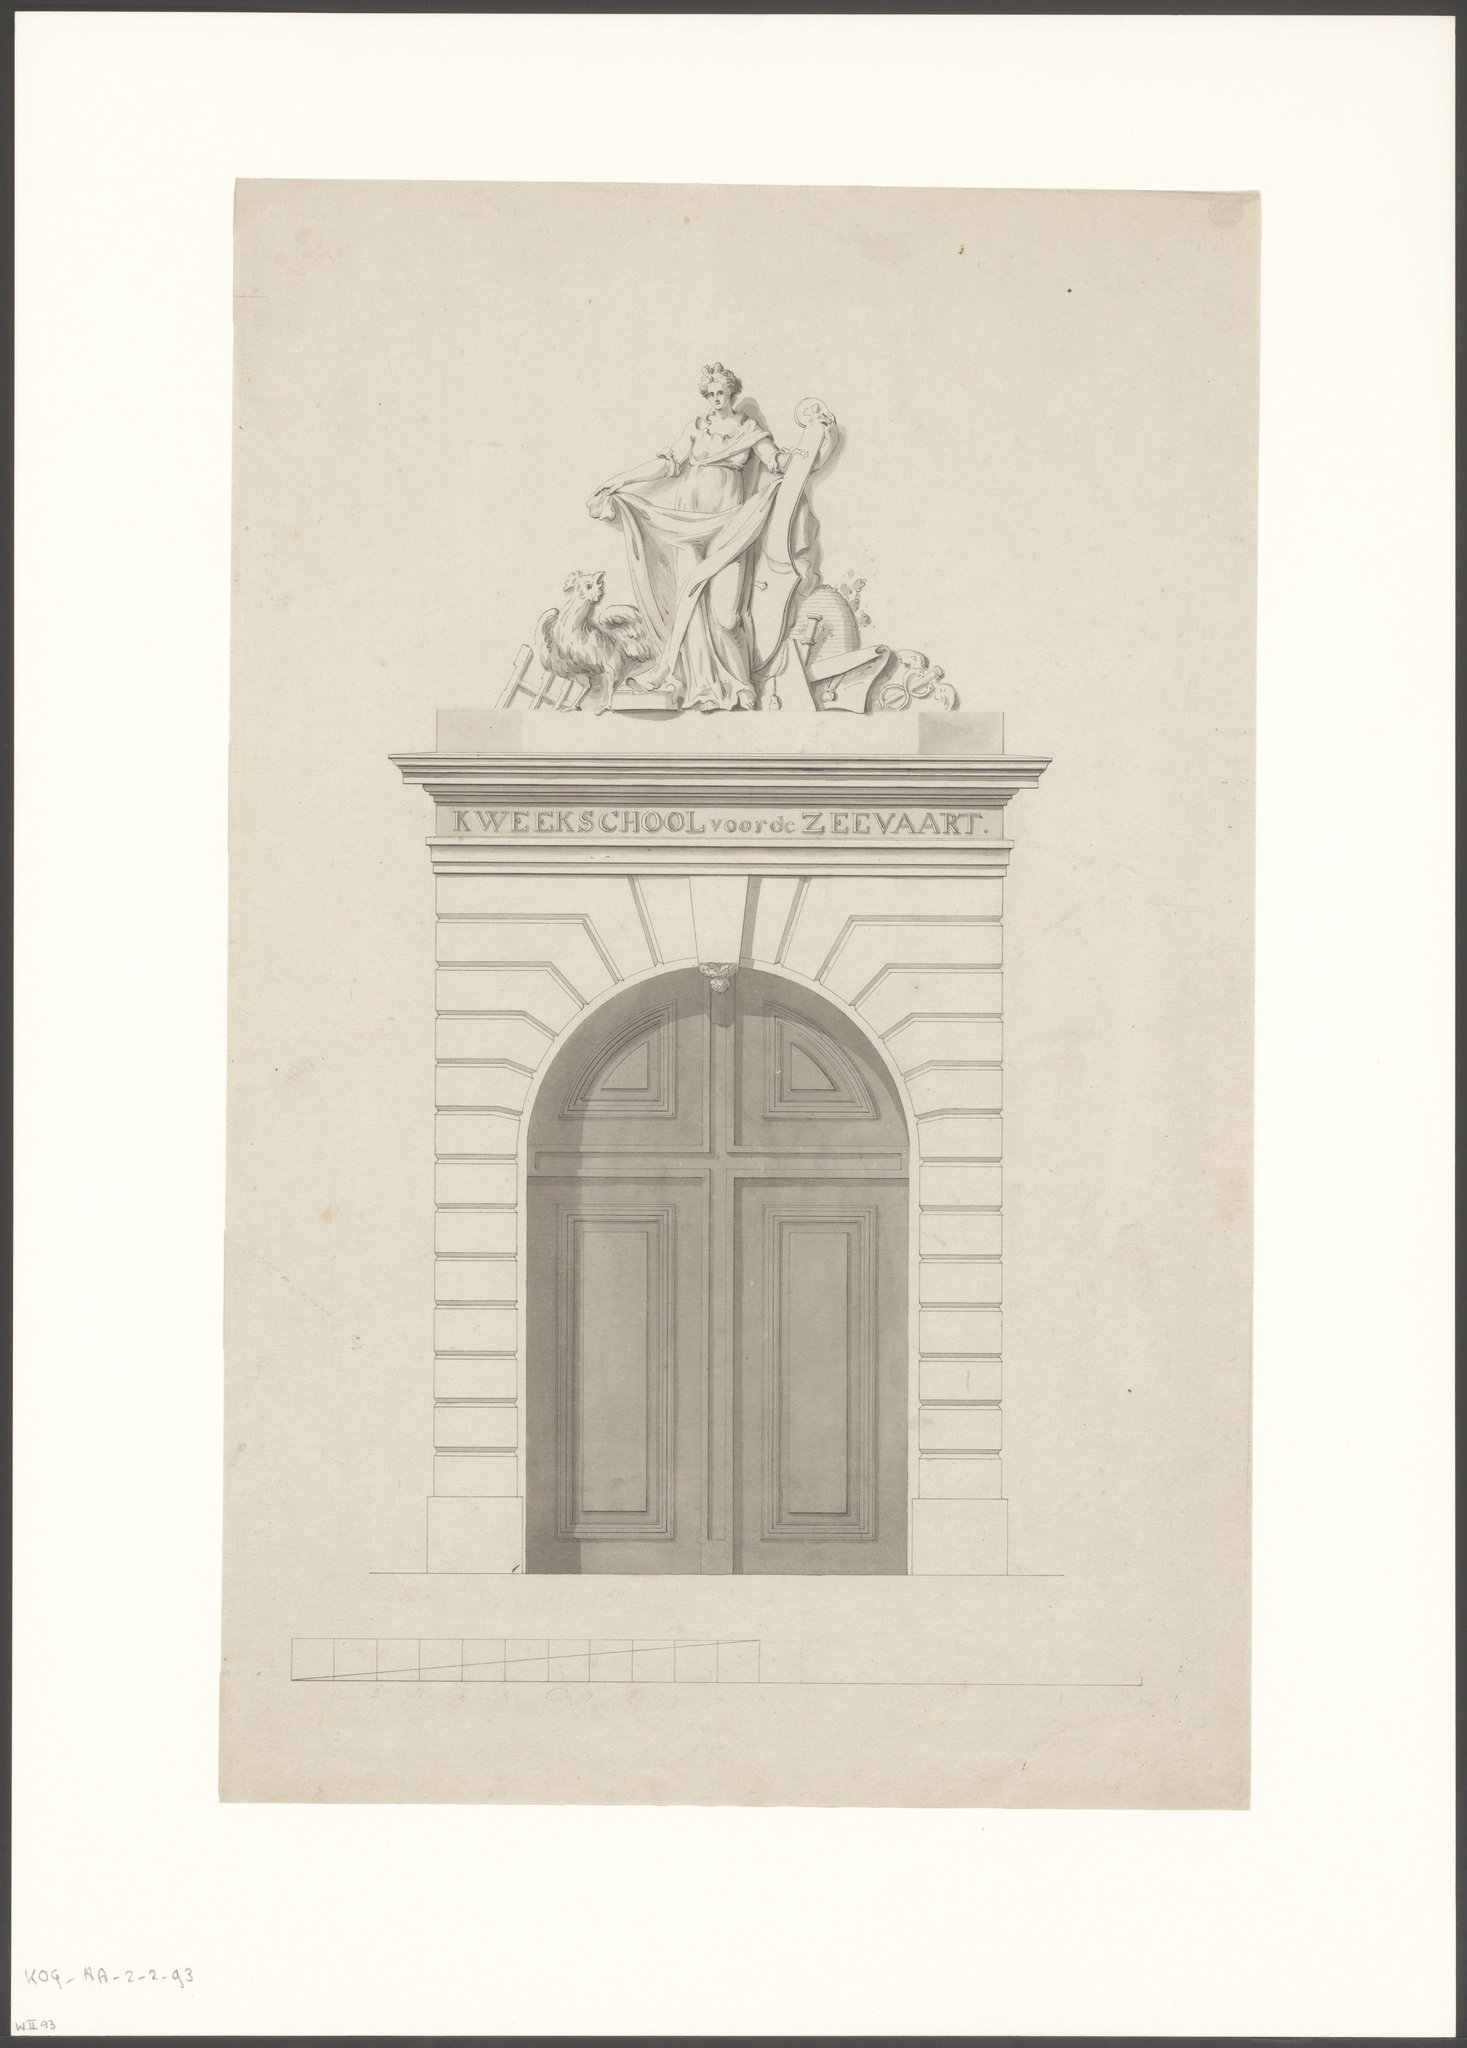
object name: drawing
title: Gevel van de Kweekschool voor de Zeevaart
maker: anthony ziesenis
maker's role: draughtsman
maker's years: 1731-1801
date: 1741-1801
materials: ink, paper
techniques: brush, pen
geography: amsterdam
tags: gate, entrance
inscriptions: collector's mark: Lugt 800a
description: Tekening binnen de Atlas Van Eck ingedeeld op wijknummer 2.